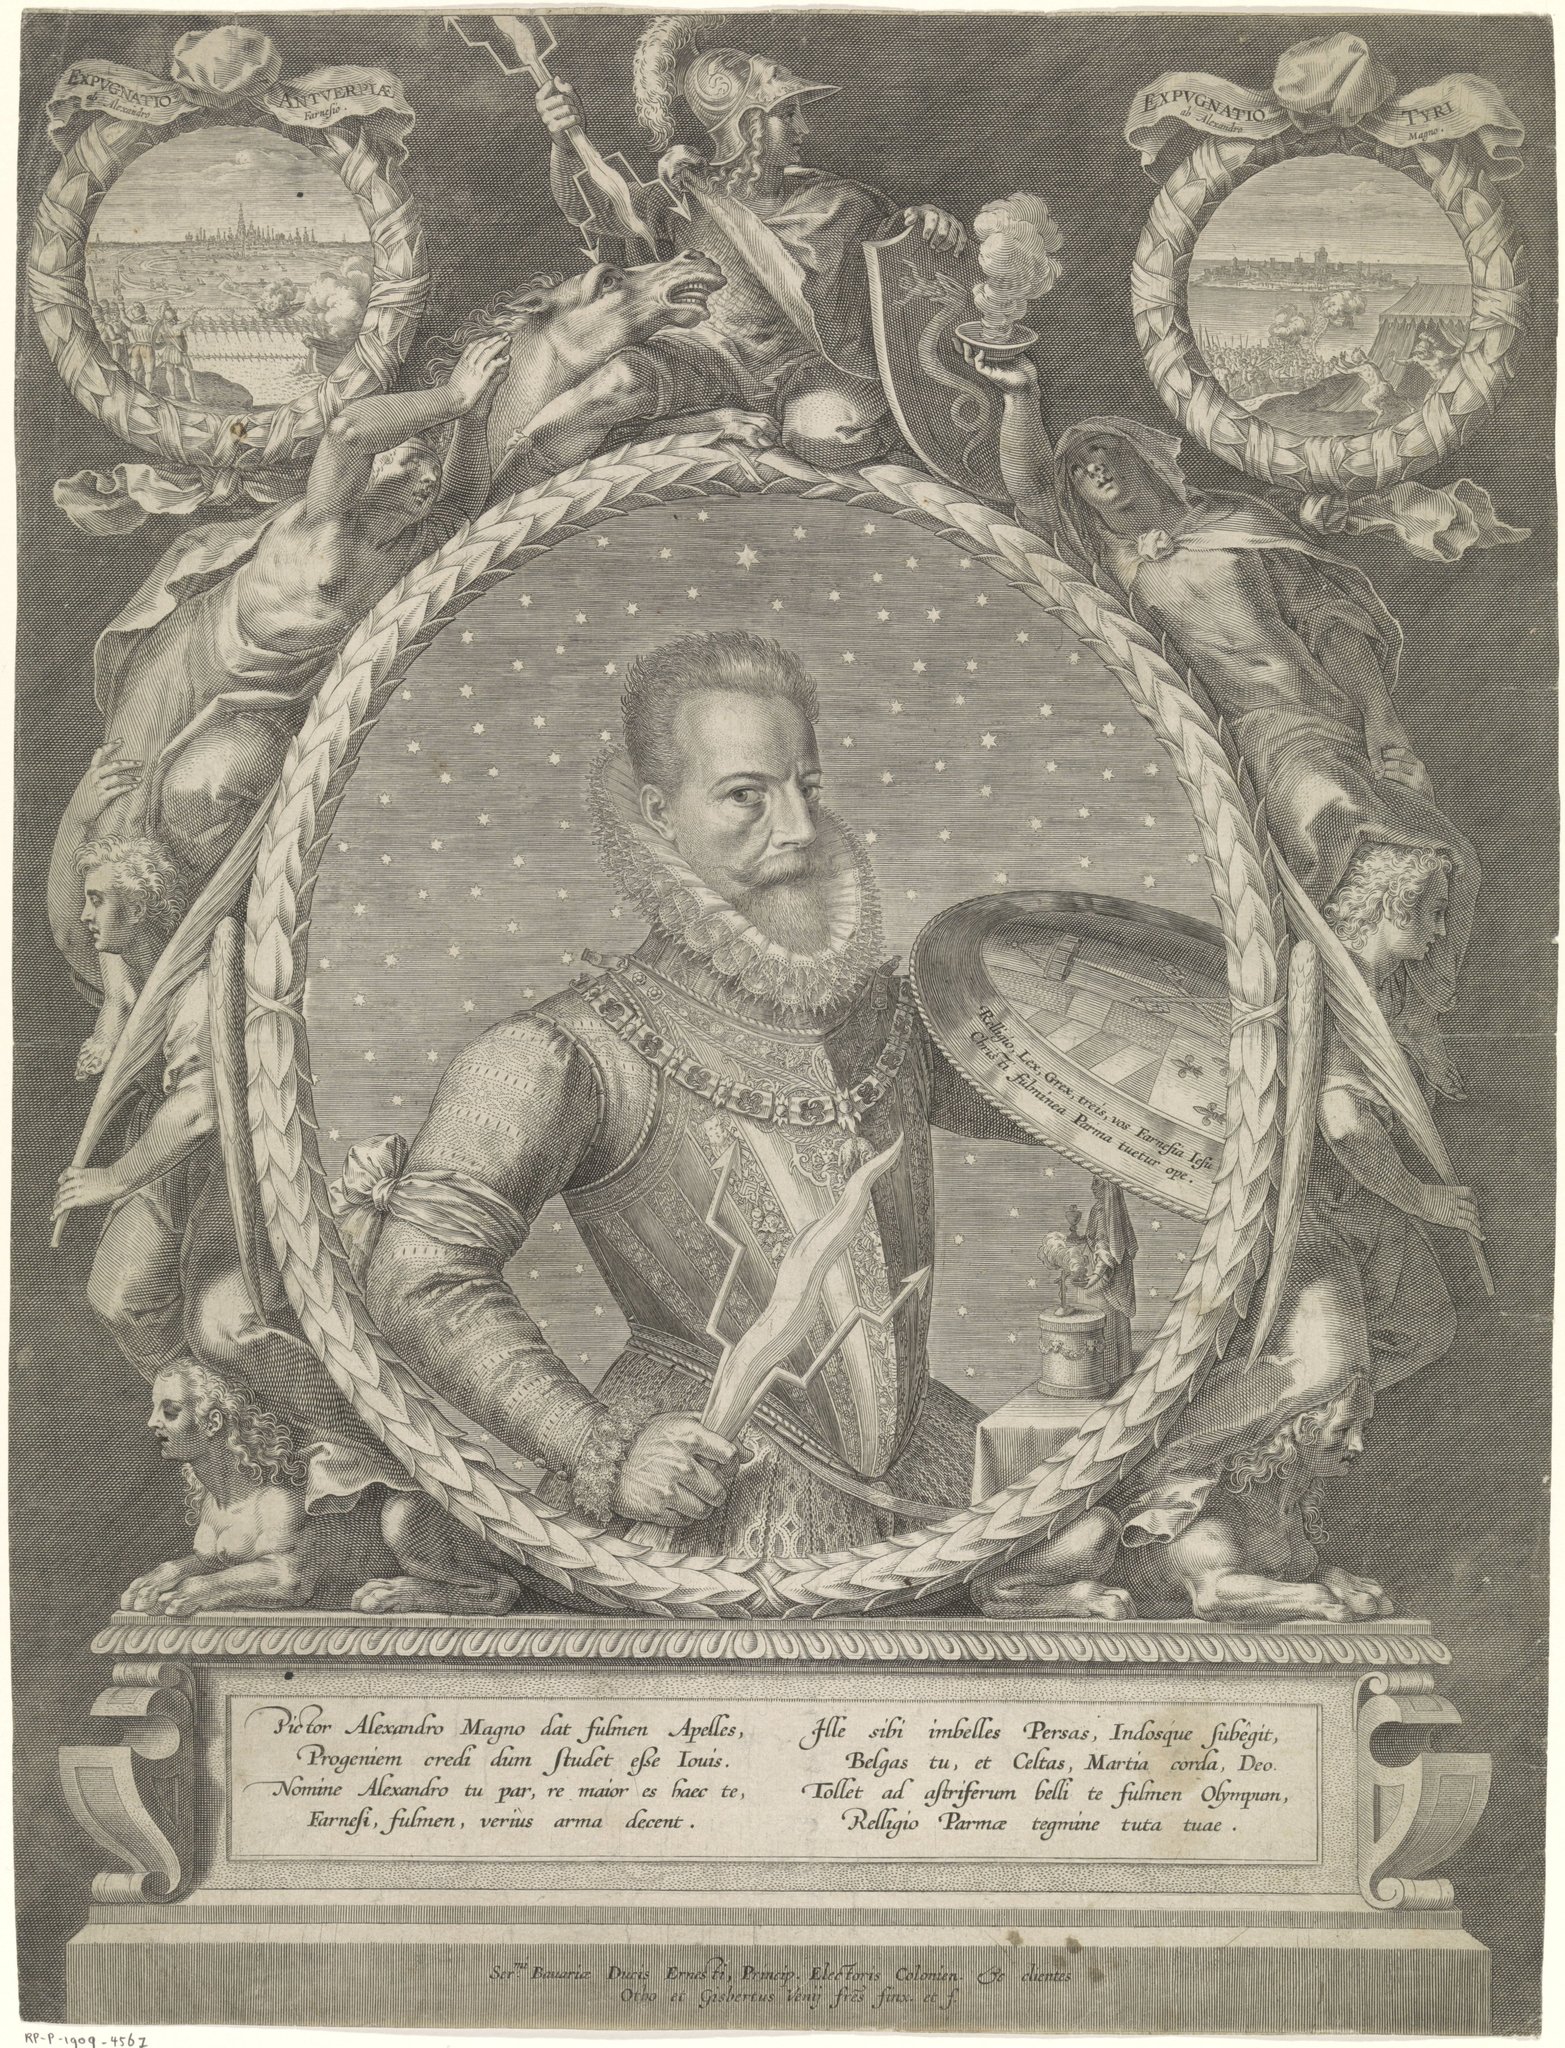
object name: print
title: Portret van Alessandro Farnese, hertog van Parma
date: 1585-1612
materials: paper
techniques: engraving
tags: rome, alessandro farnese (landvoogd van de nederlanden en hertog van parma en piacenza), antwerp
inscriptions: collector's mark: Lugt 2228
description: Alessandro Farnese, hertog van Parma. Gekleed in harnas, met een schild in de linkerhand, een bliksemschicht in de rechterhand. Ovaal in ornamentale omlijsting met allegorische figuren en onderaan twee sfinxen. Linksboven een medaillon met een voorstelling van de belegering van Antwerpen door Alessandro Farnese en rechts een medaillon met een voorstelling van de belegering van Tyrus door Alexander de Grote.